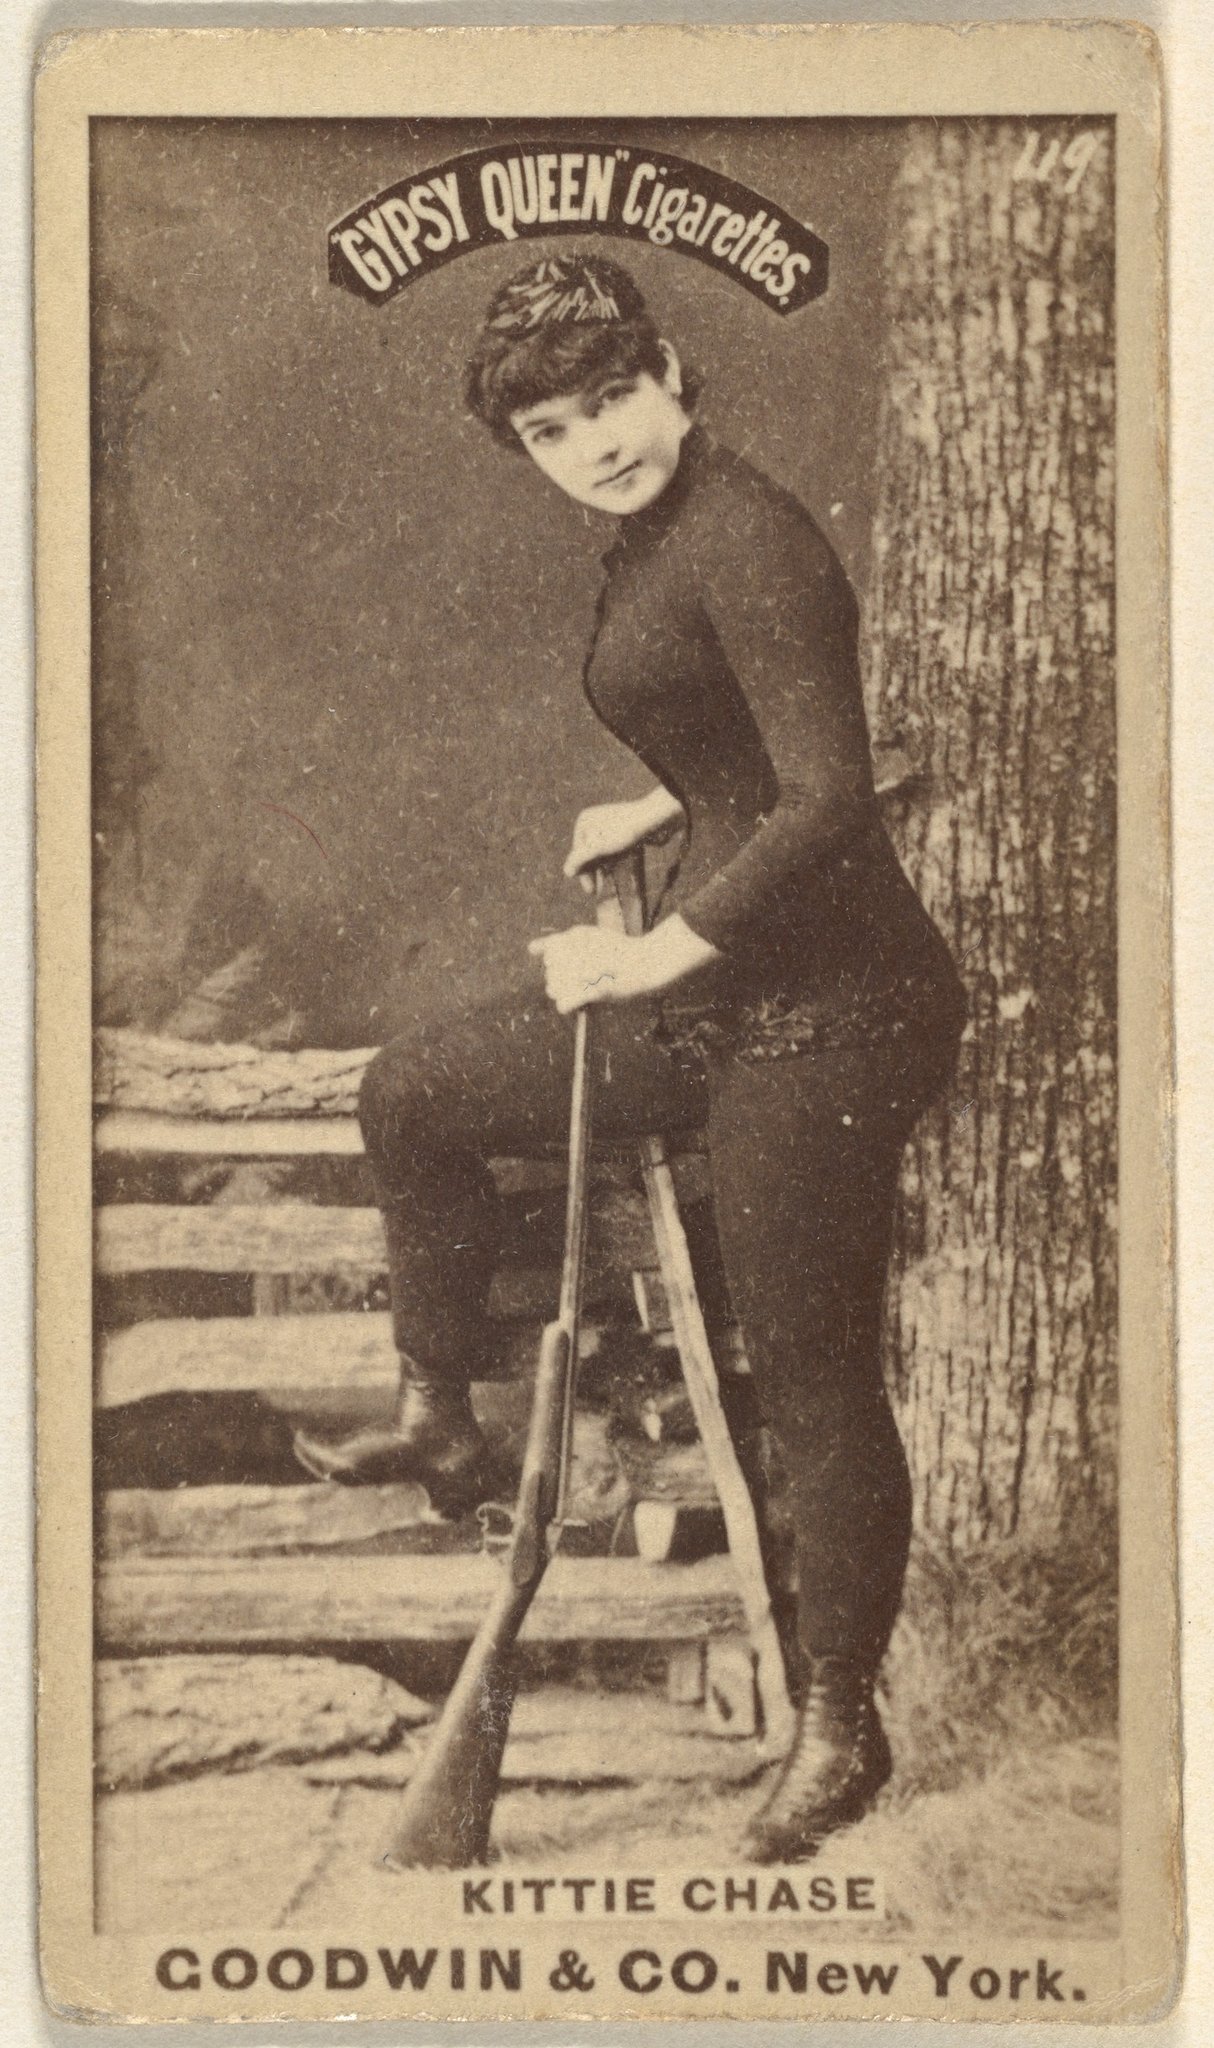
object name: photograph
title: Kittie Chase, from the Actors and Actresses series (N171) for Gypsy Queen Cigarettes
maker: goodwin & company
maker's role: publisher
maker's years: 1850-1950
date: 1886-1890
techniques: albumen silver print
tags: firearms,portraits,women